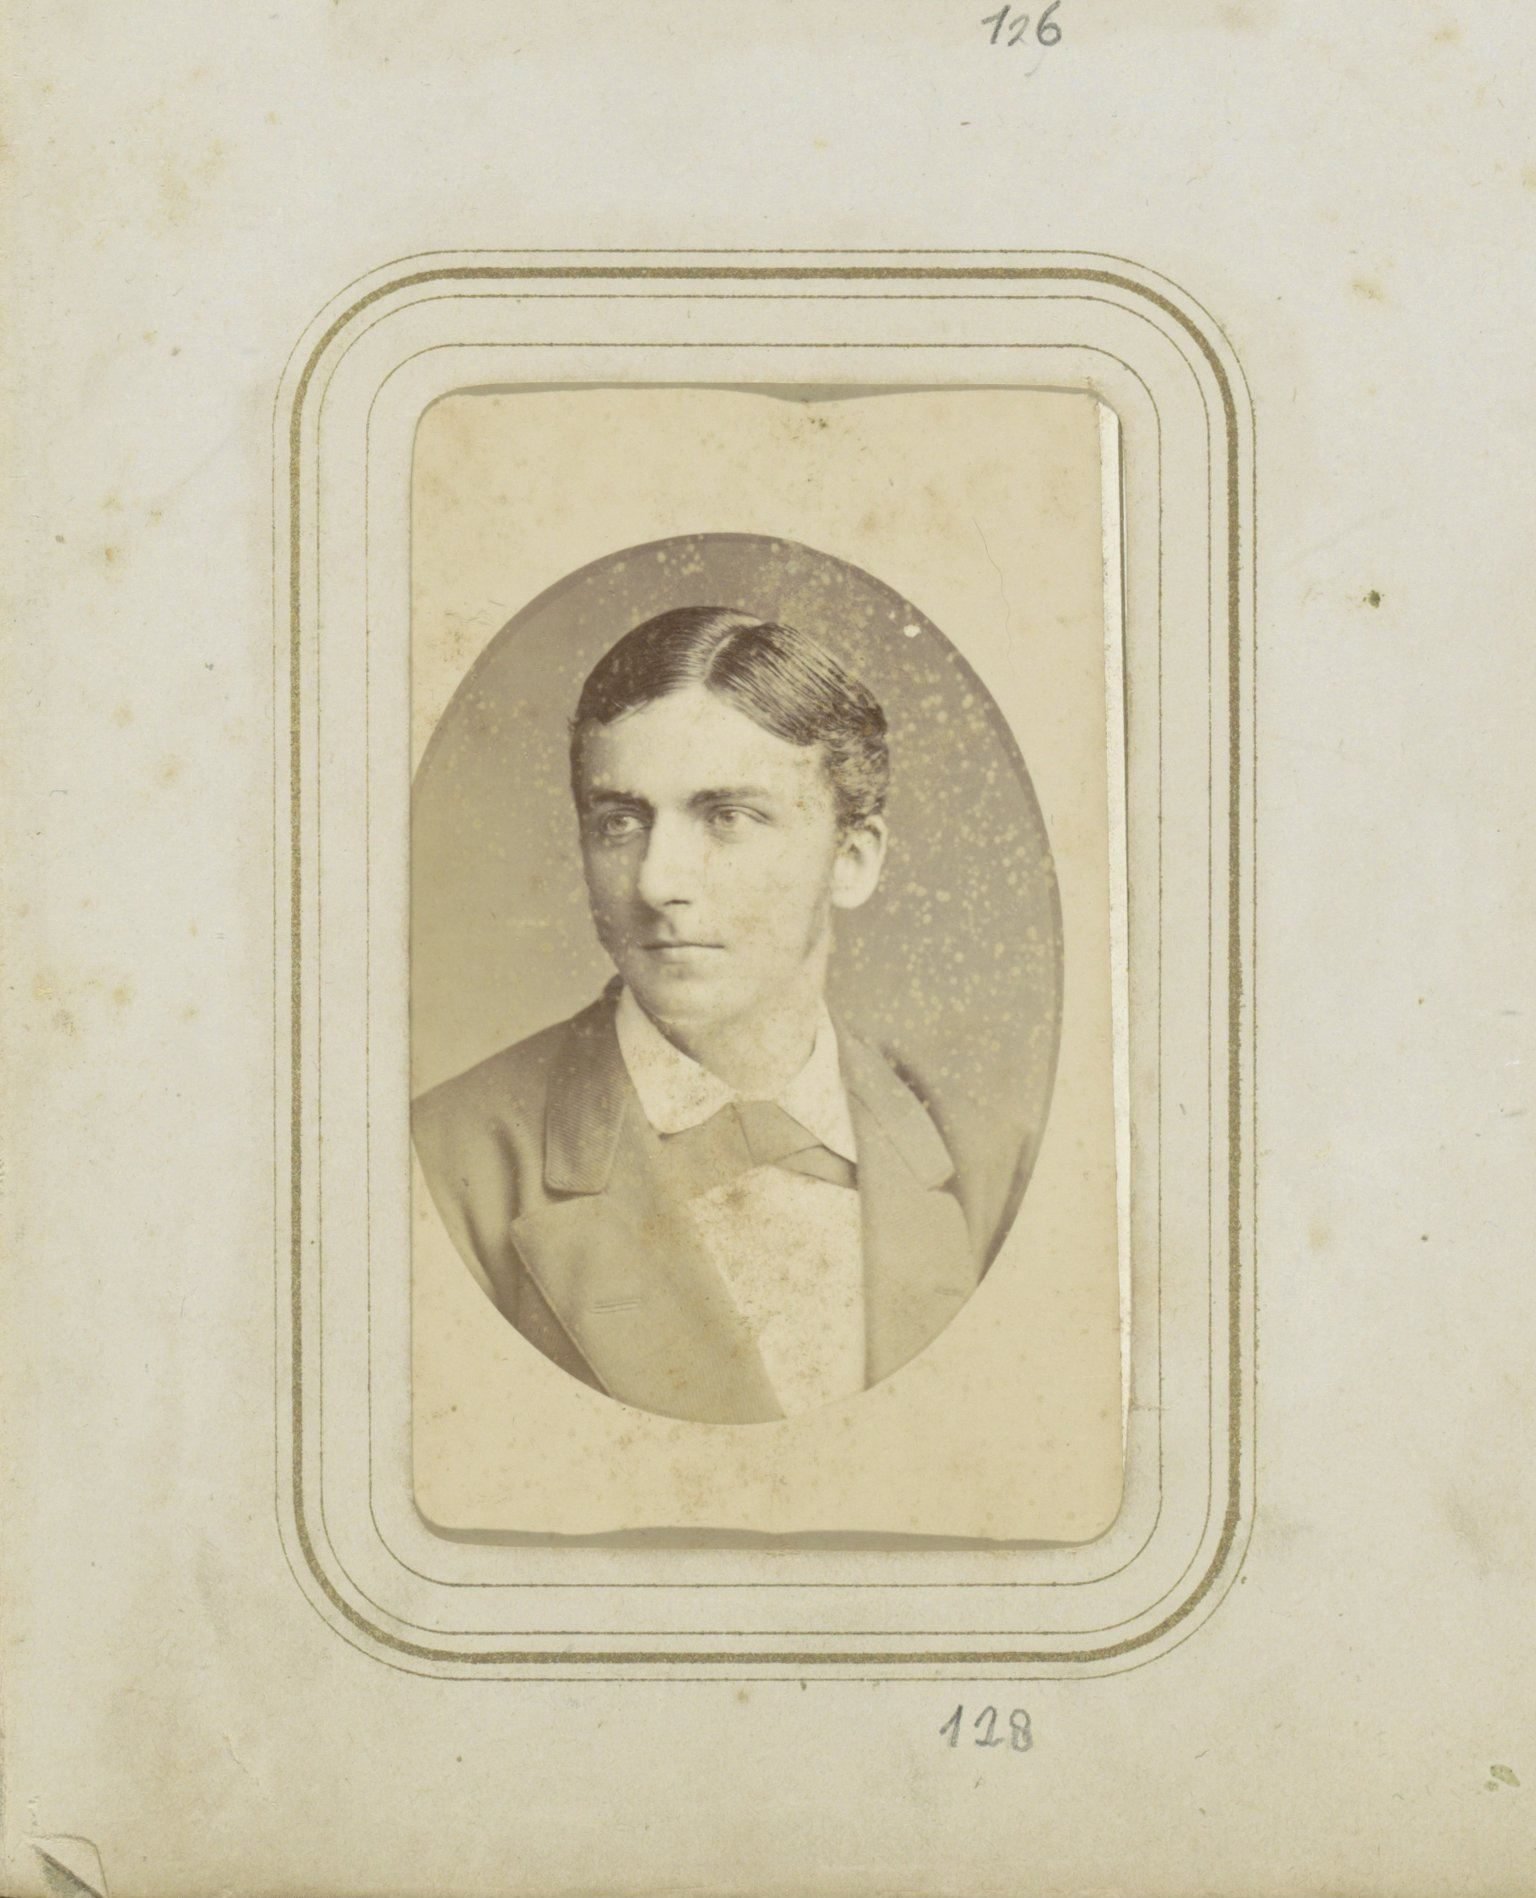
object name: carte de visite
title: Portret van een man met bakkebaarden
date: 1875-1880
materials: cardboard, photographic support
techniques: albumen print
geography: batavia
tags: sideburns, historical persons, neck-gear ~ clothing, clothing for the upper part of the body, family, relationship, descent, hairdress, batavia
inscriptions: address: ‘Batavia.’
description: Onderdeel van Familiealbum van H.W.F. Ligtenberg en L.M. Swart met 149 foto's en cartes-de-visite.